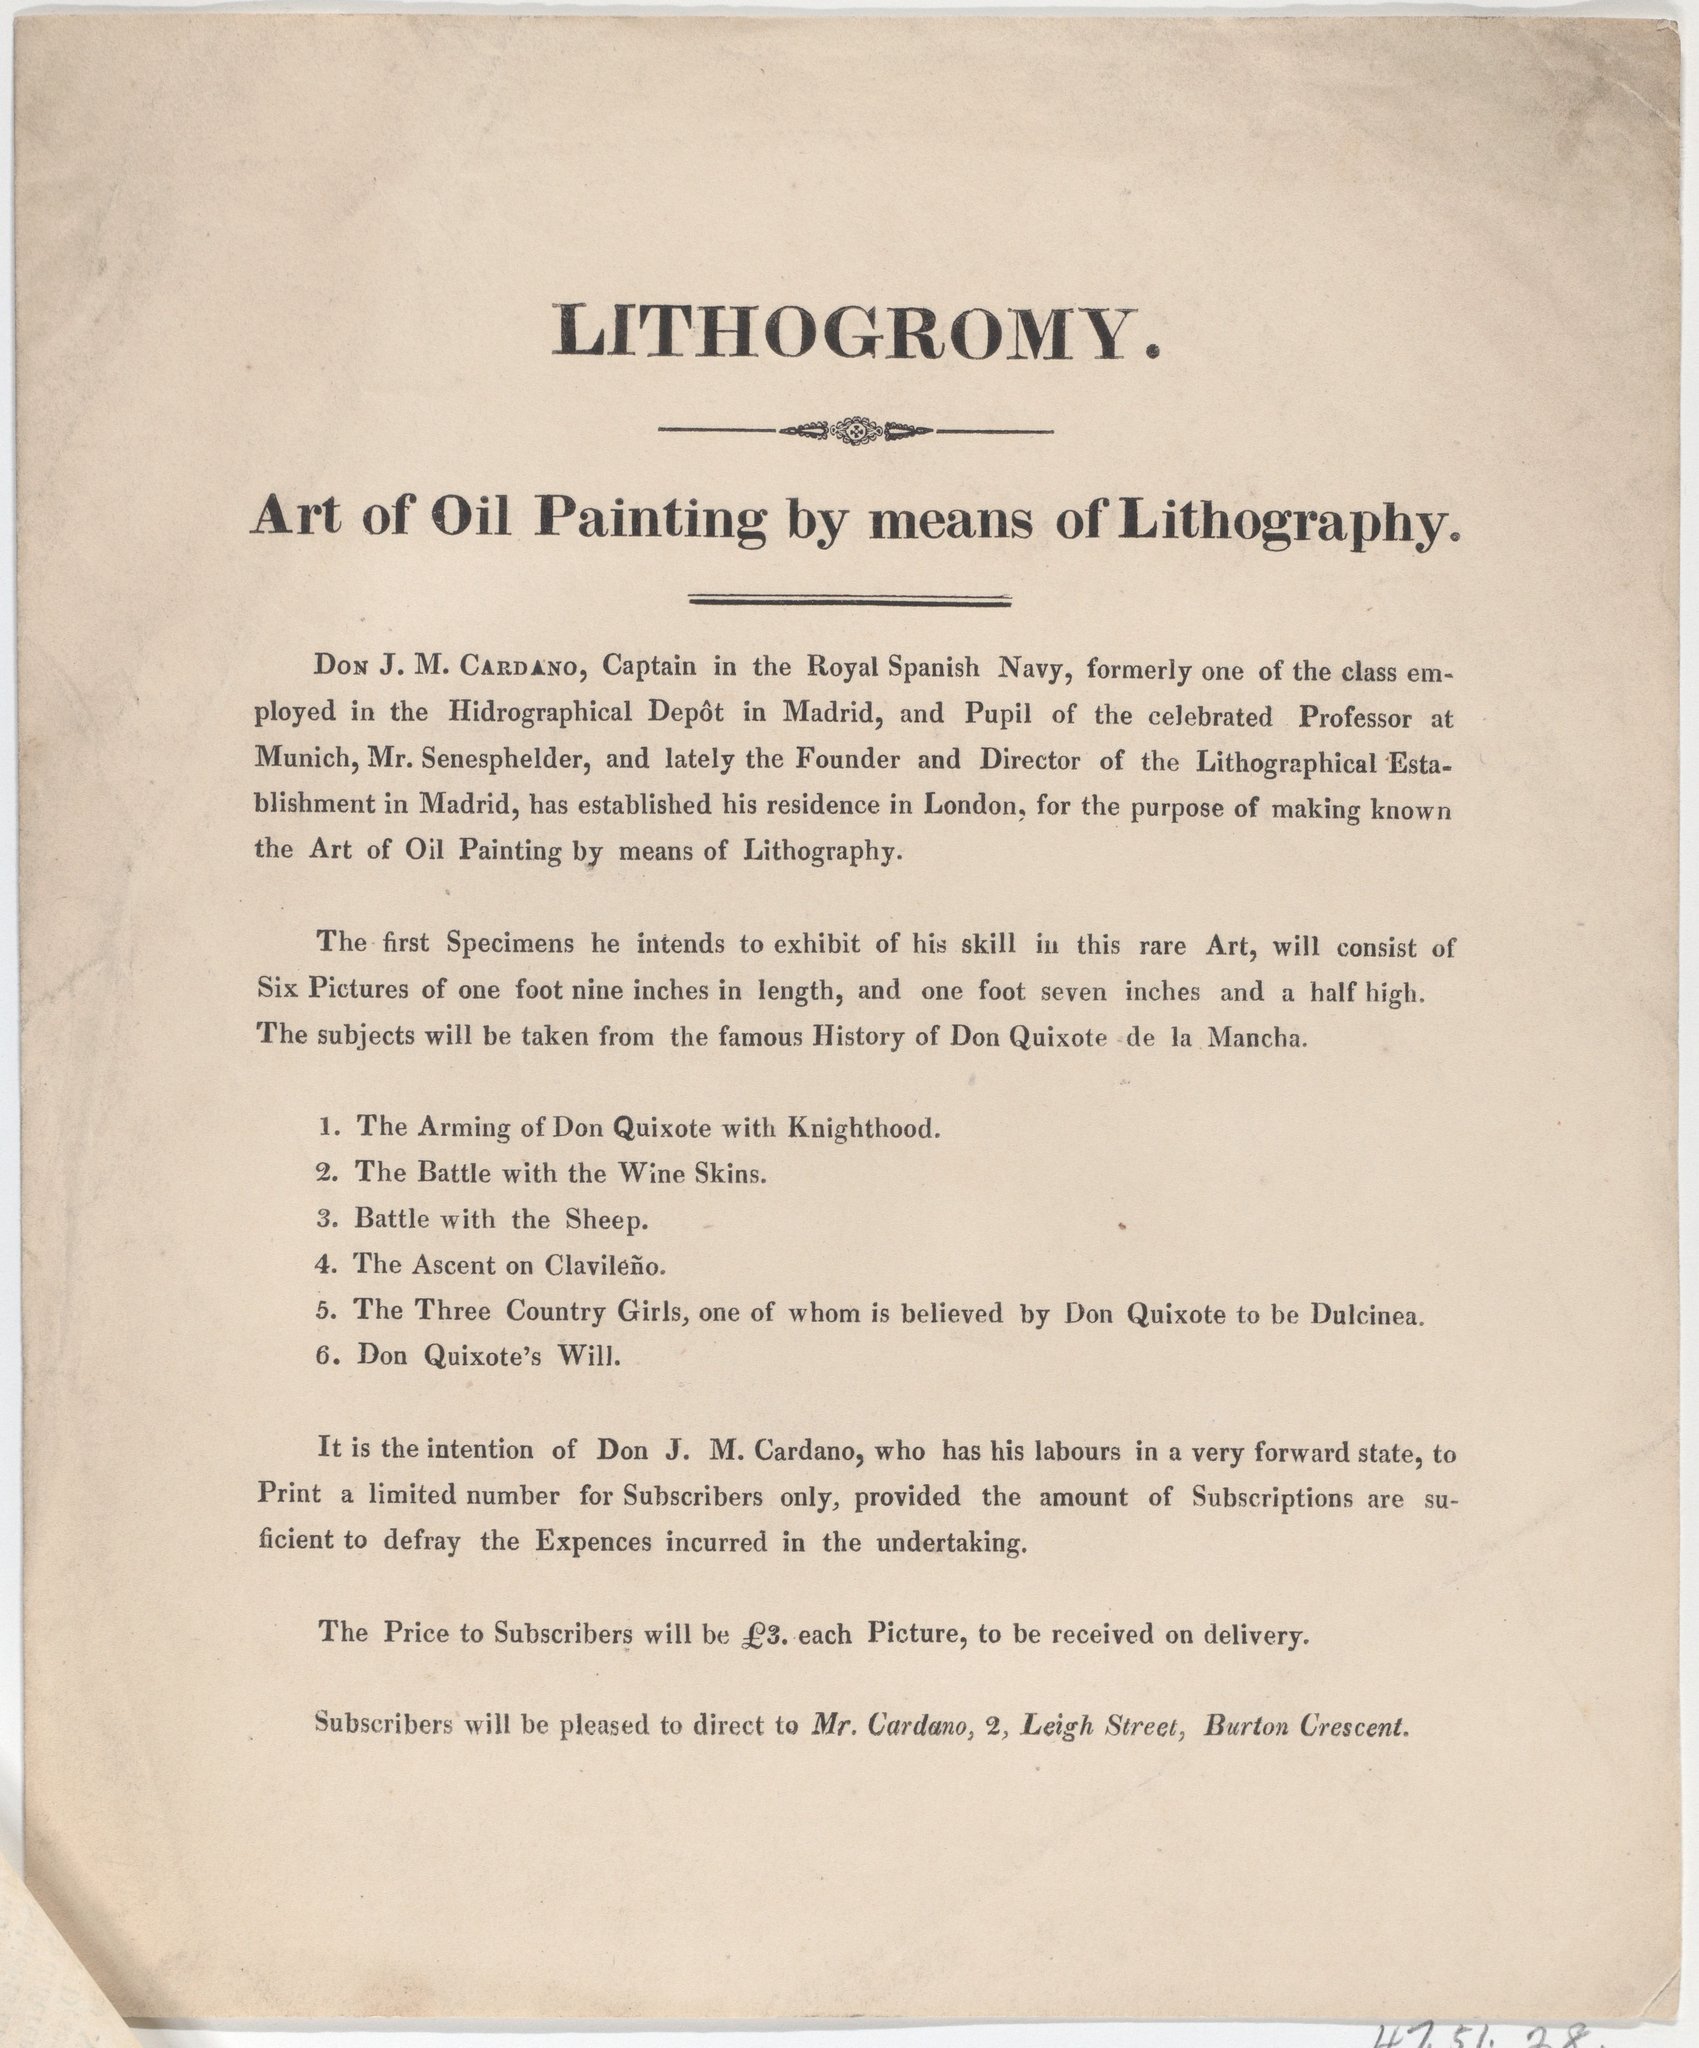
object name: print, trade card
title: Trade Card for José Maria Cardano, Lithographer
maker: anonymous, british, 19th century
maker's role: artist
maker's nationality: british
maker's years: 1800-1900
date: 1801-1900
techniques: letterpress